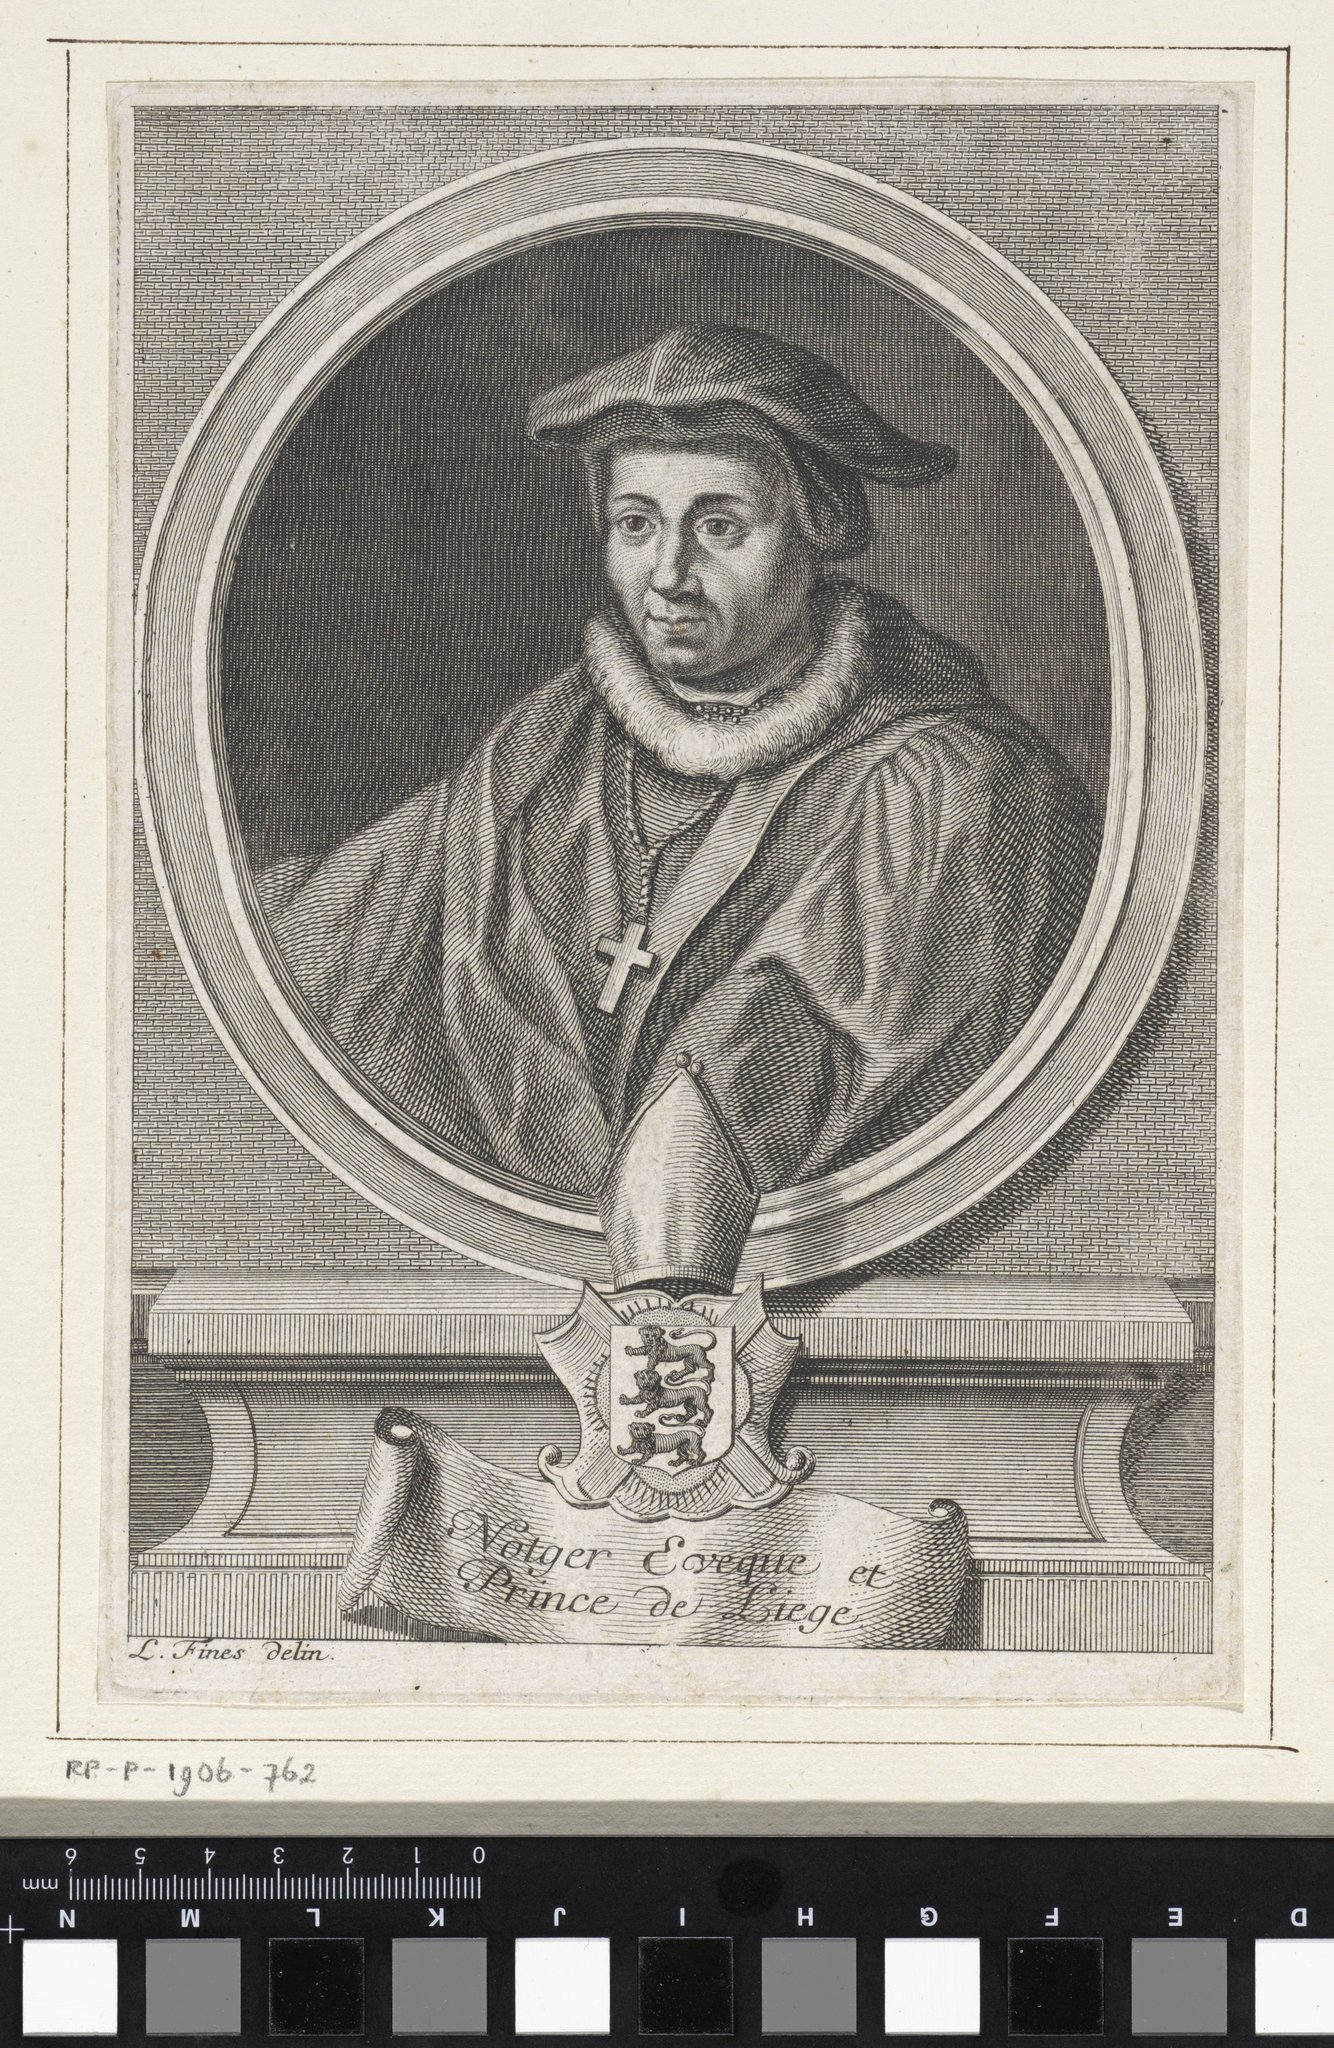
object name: print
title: Portret van Notger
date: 1620-1699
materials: paper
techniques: engraving, roulette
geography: liège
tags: liège, historical persons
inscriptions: collector's mark: Lugt 2228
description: Portret van de prinsbisschop Notger in religieuze kledij. Hij draagt een baret en op zijn borst hangt een kruis. Onder de ovale omlijsting is zijn wapen te zien en een banderol met zijn naam en functie.